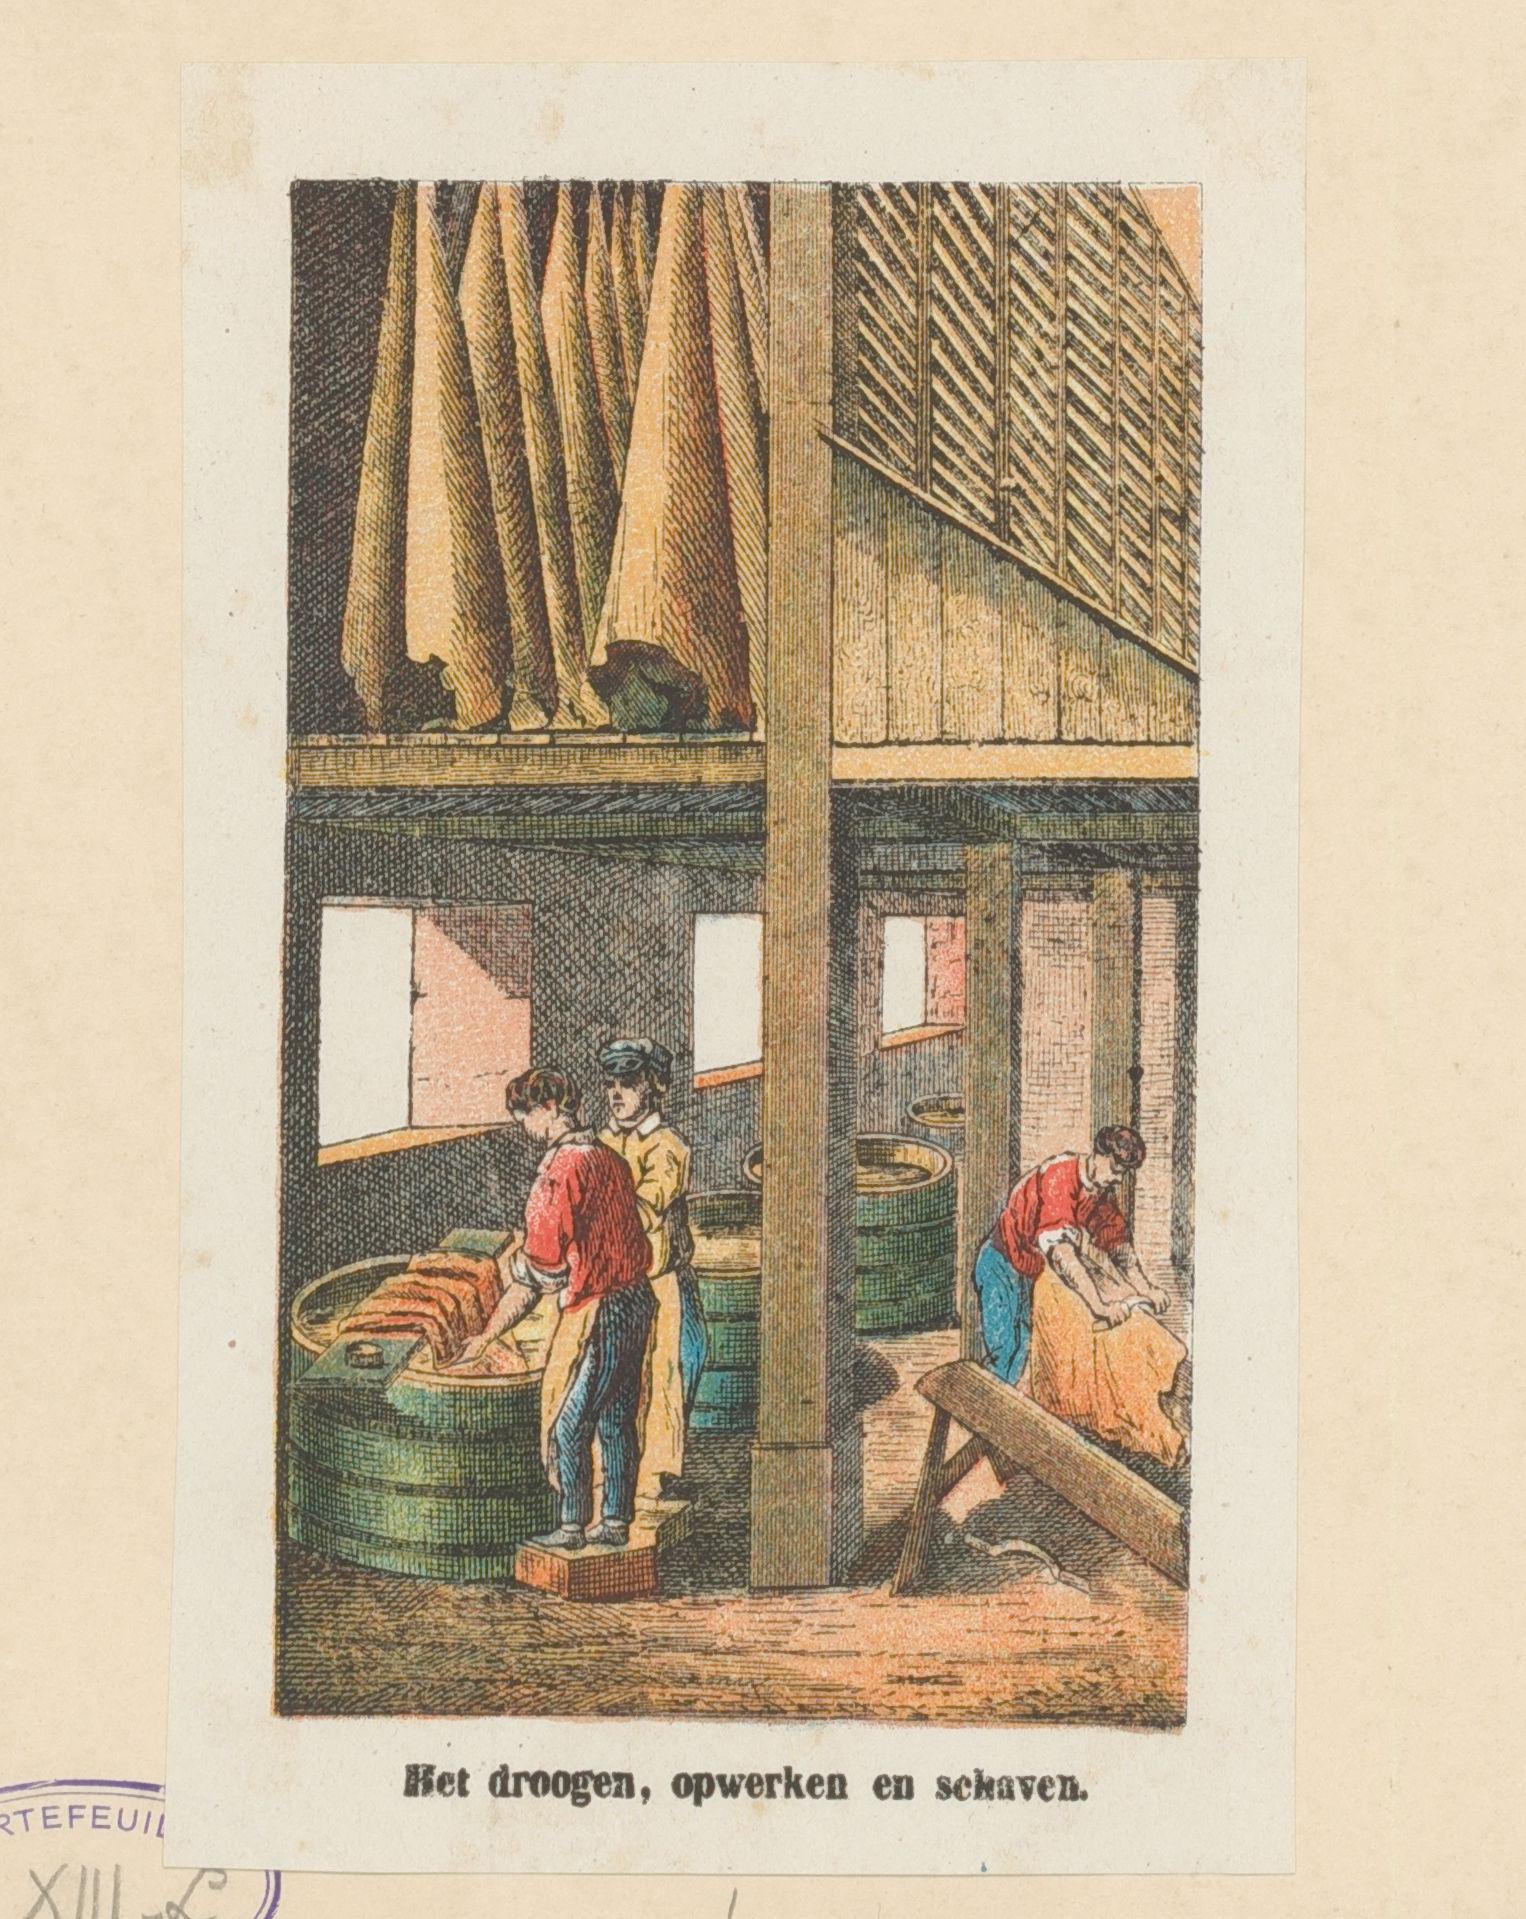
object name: print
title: Drogen, opwerken en schaven van leer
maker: Anonymous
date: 1870-1880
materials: paper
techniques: lithograph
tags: leather industry, manufacture of leather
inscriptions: stamp, stamp, collector's mark: Lugt 1641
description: Onderwerpsrubrieken binnen de Atlas Zeden en Gewoonten: Handel, Nijverheid en verkeer, Beroep en bedrijf, Mannelijk, Bewerkers van het leder.